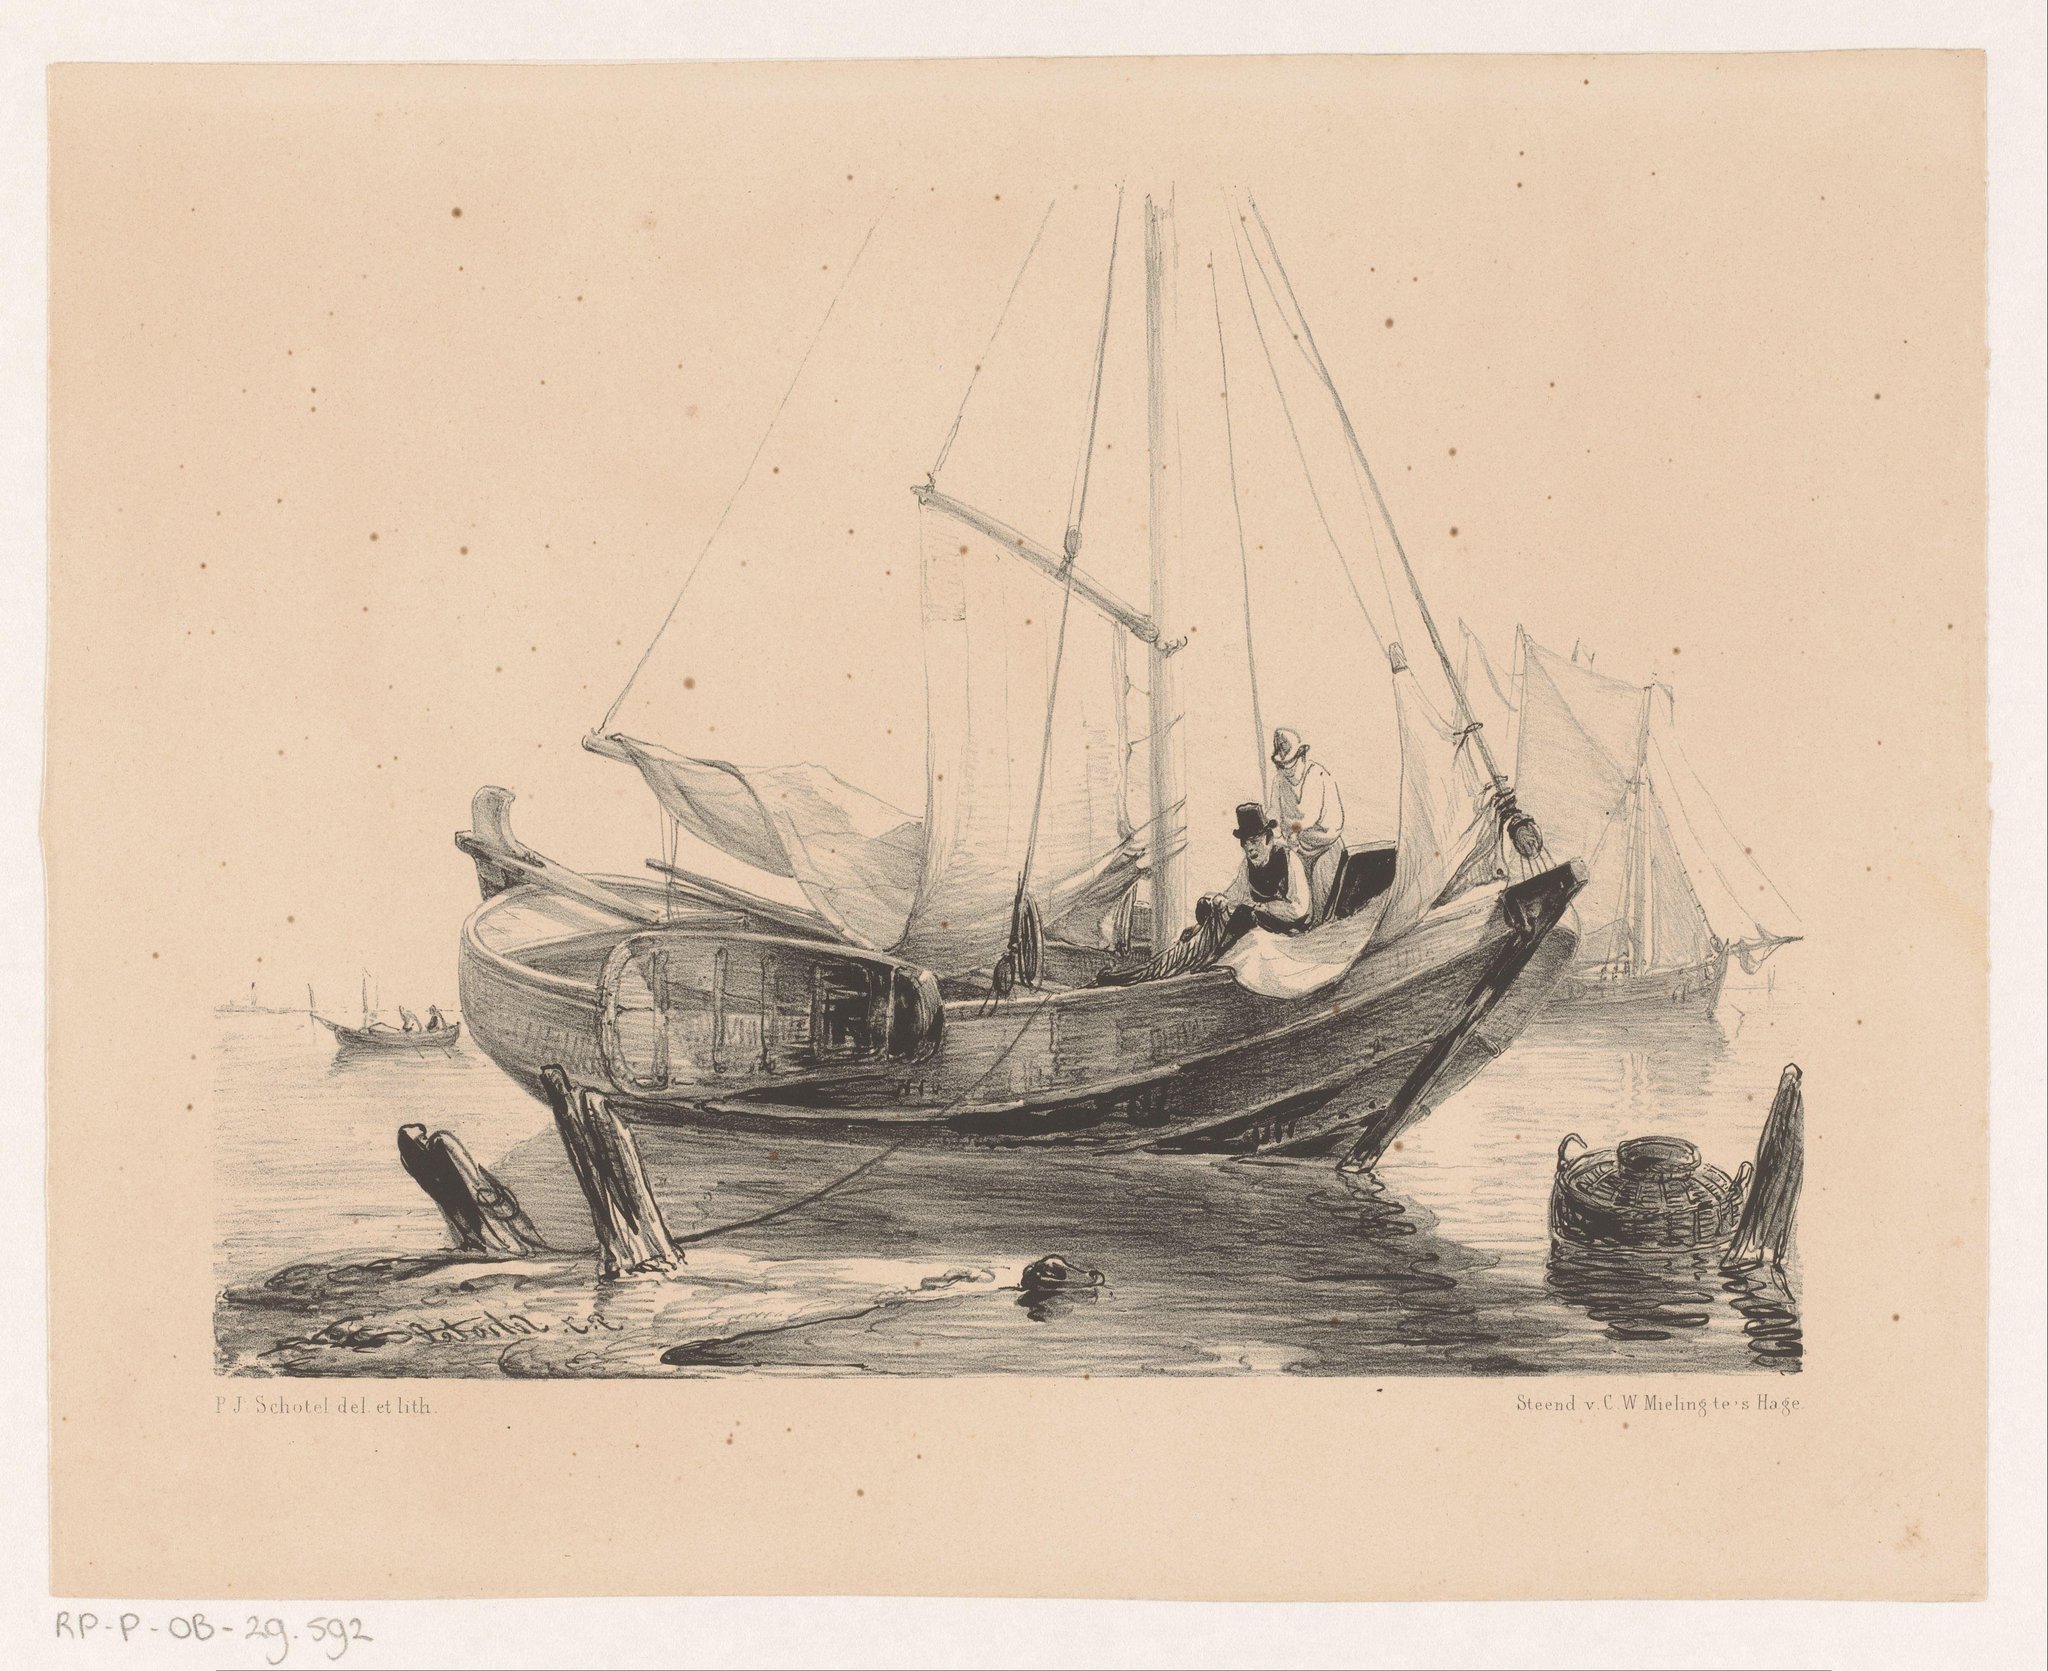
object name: print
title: Aangemeerde zeilboot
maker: petrus johannes schotel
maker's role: draughtsman, painter, print maker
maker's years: 1808-1865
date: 1847-1865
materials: paper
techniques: lithograph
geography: the hague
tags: sailing-ship, sailing-boat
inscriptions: collector's mark: Lugt 2228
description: Twee figuren op een zeilboot op water met een touw rond een bolder op de oever.